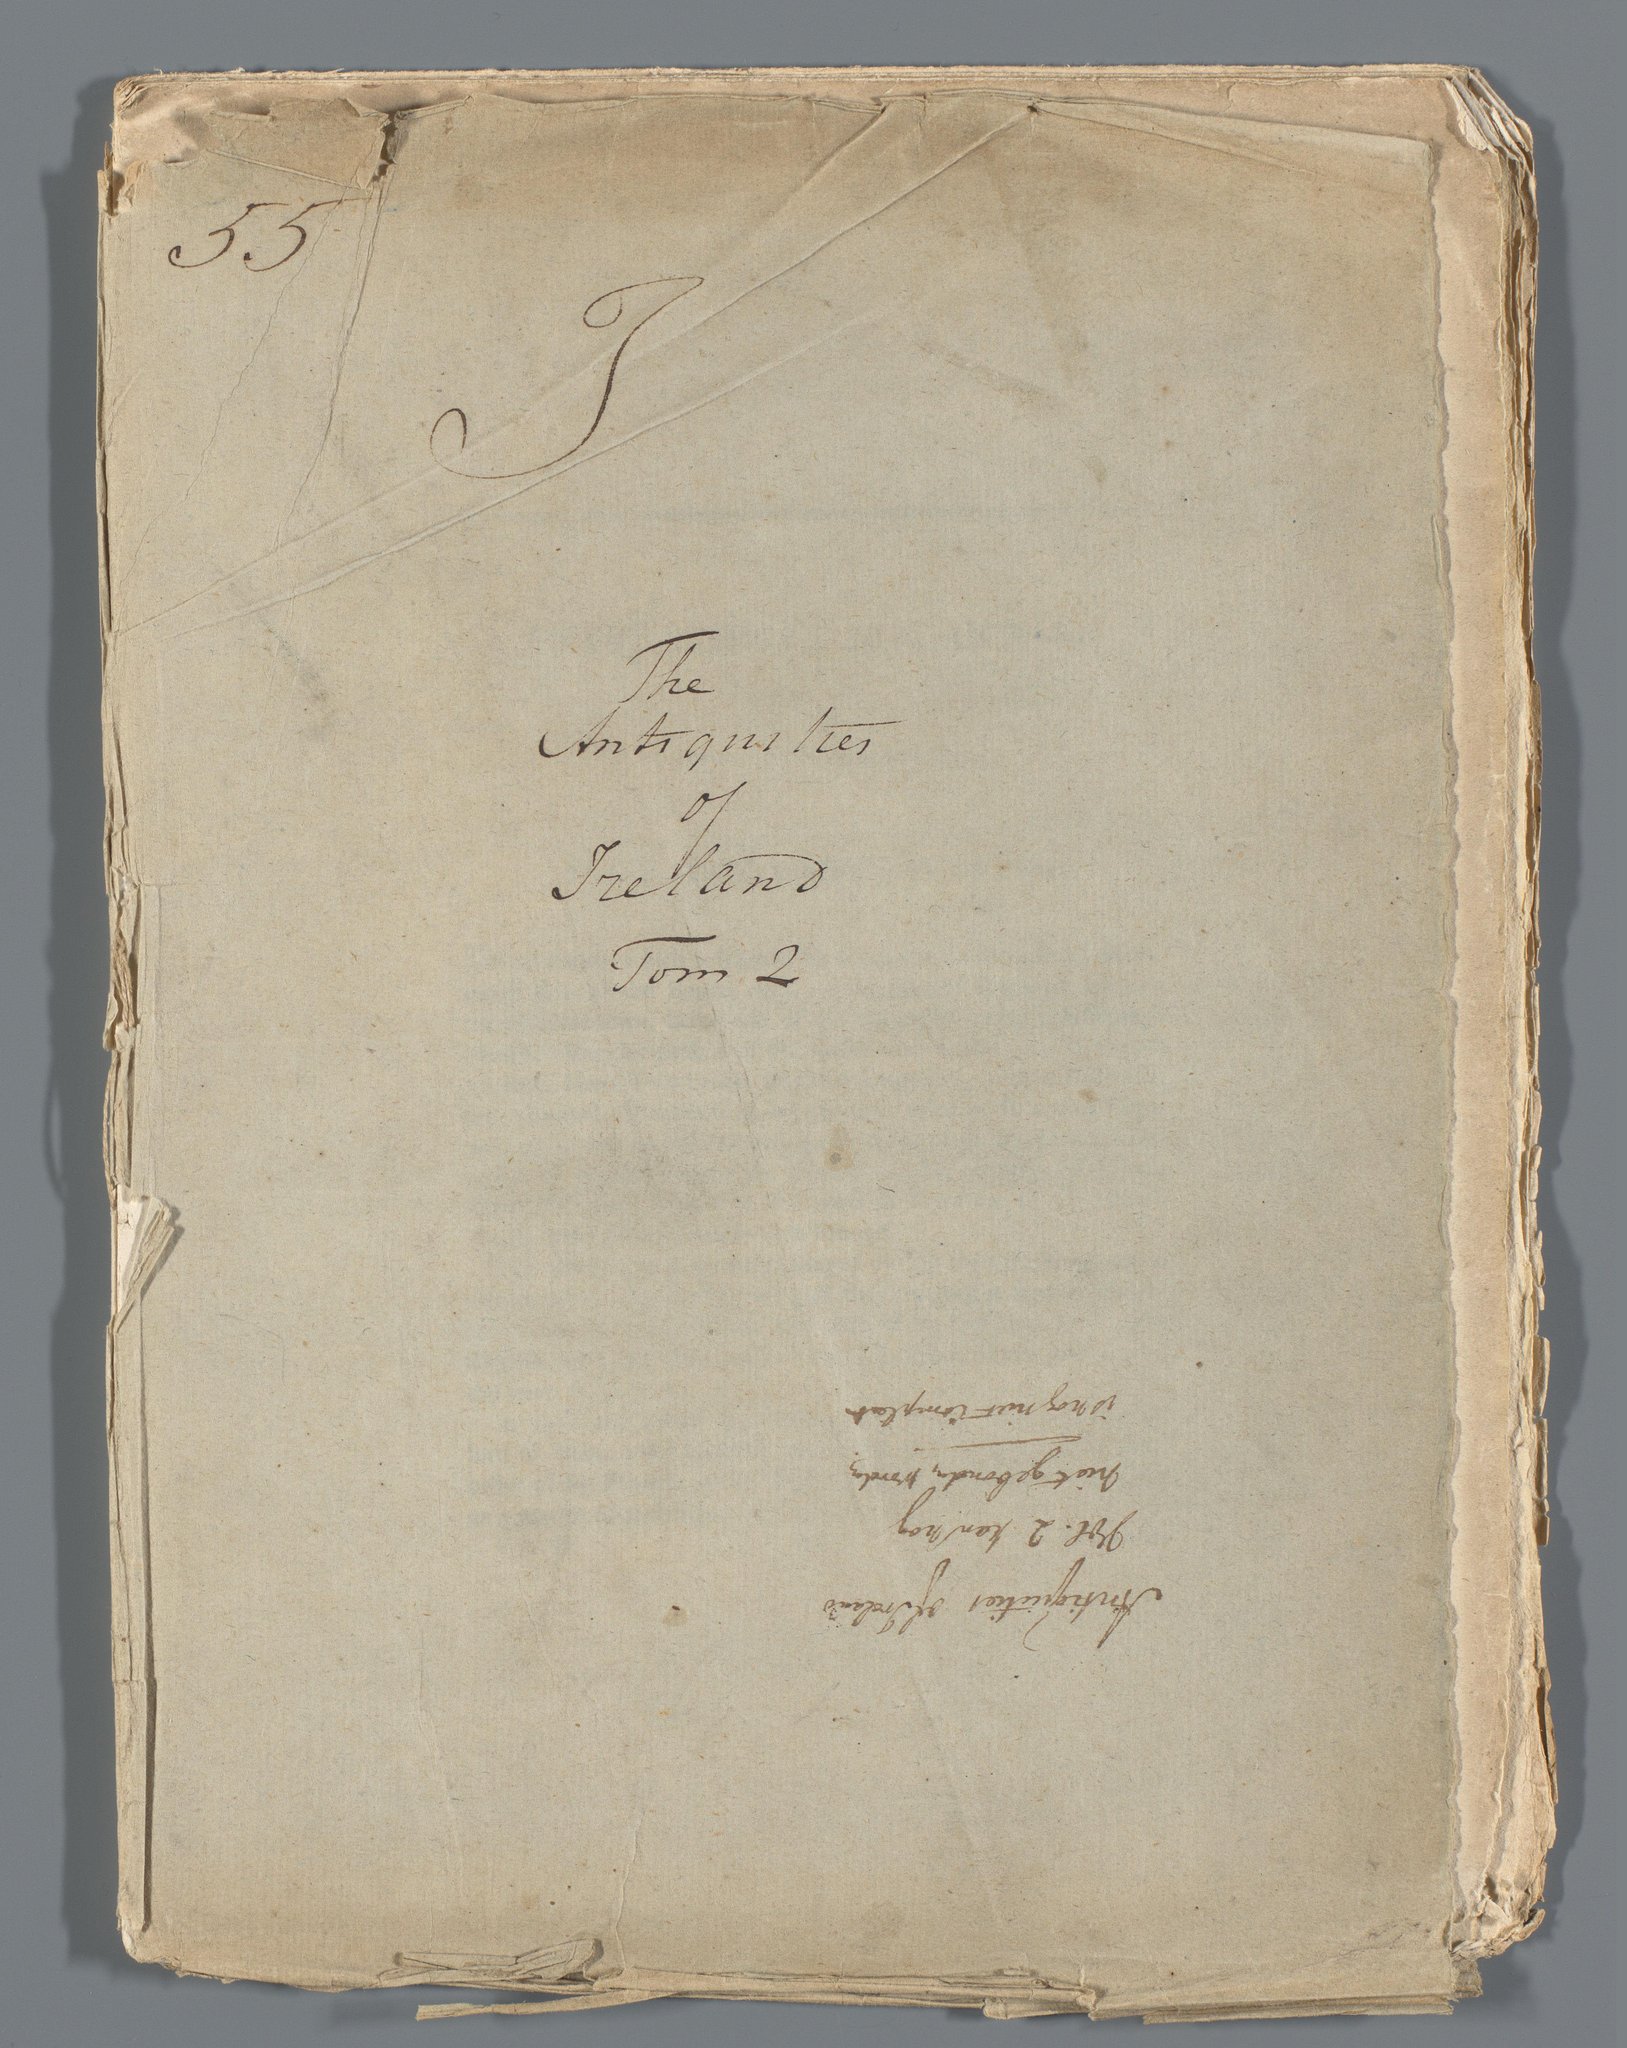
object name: book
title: Antiquiteiten in Ierland, deel 2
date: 1795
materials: paper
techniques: etching, letterpress printing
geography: london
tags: ierland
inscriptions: inscription: ‘Antiquities of Ireland vol 2 kan nog kan nog niet gebonden worden, is nog niet compleet’, inscription: ‘The Antiquities of Ireland Tom 2’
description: De tekstbladen en prenten zijn waarschijnlijk bedoeld om uit te geven als een boek over de antiquiteiten in Ierland. Francis Grose maakte eerder al een dergelijk werk over Engeland. In 1791 ging hij naar Ierland om hierover een boek te maken. Hij overleed echter kort na vertrek en Edward Ledwich nam de taak een publicatie te maken over Ierland van Grose over. Uiteindelijk zijn er twee delen verschenen in ca. 1791 en 1795.